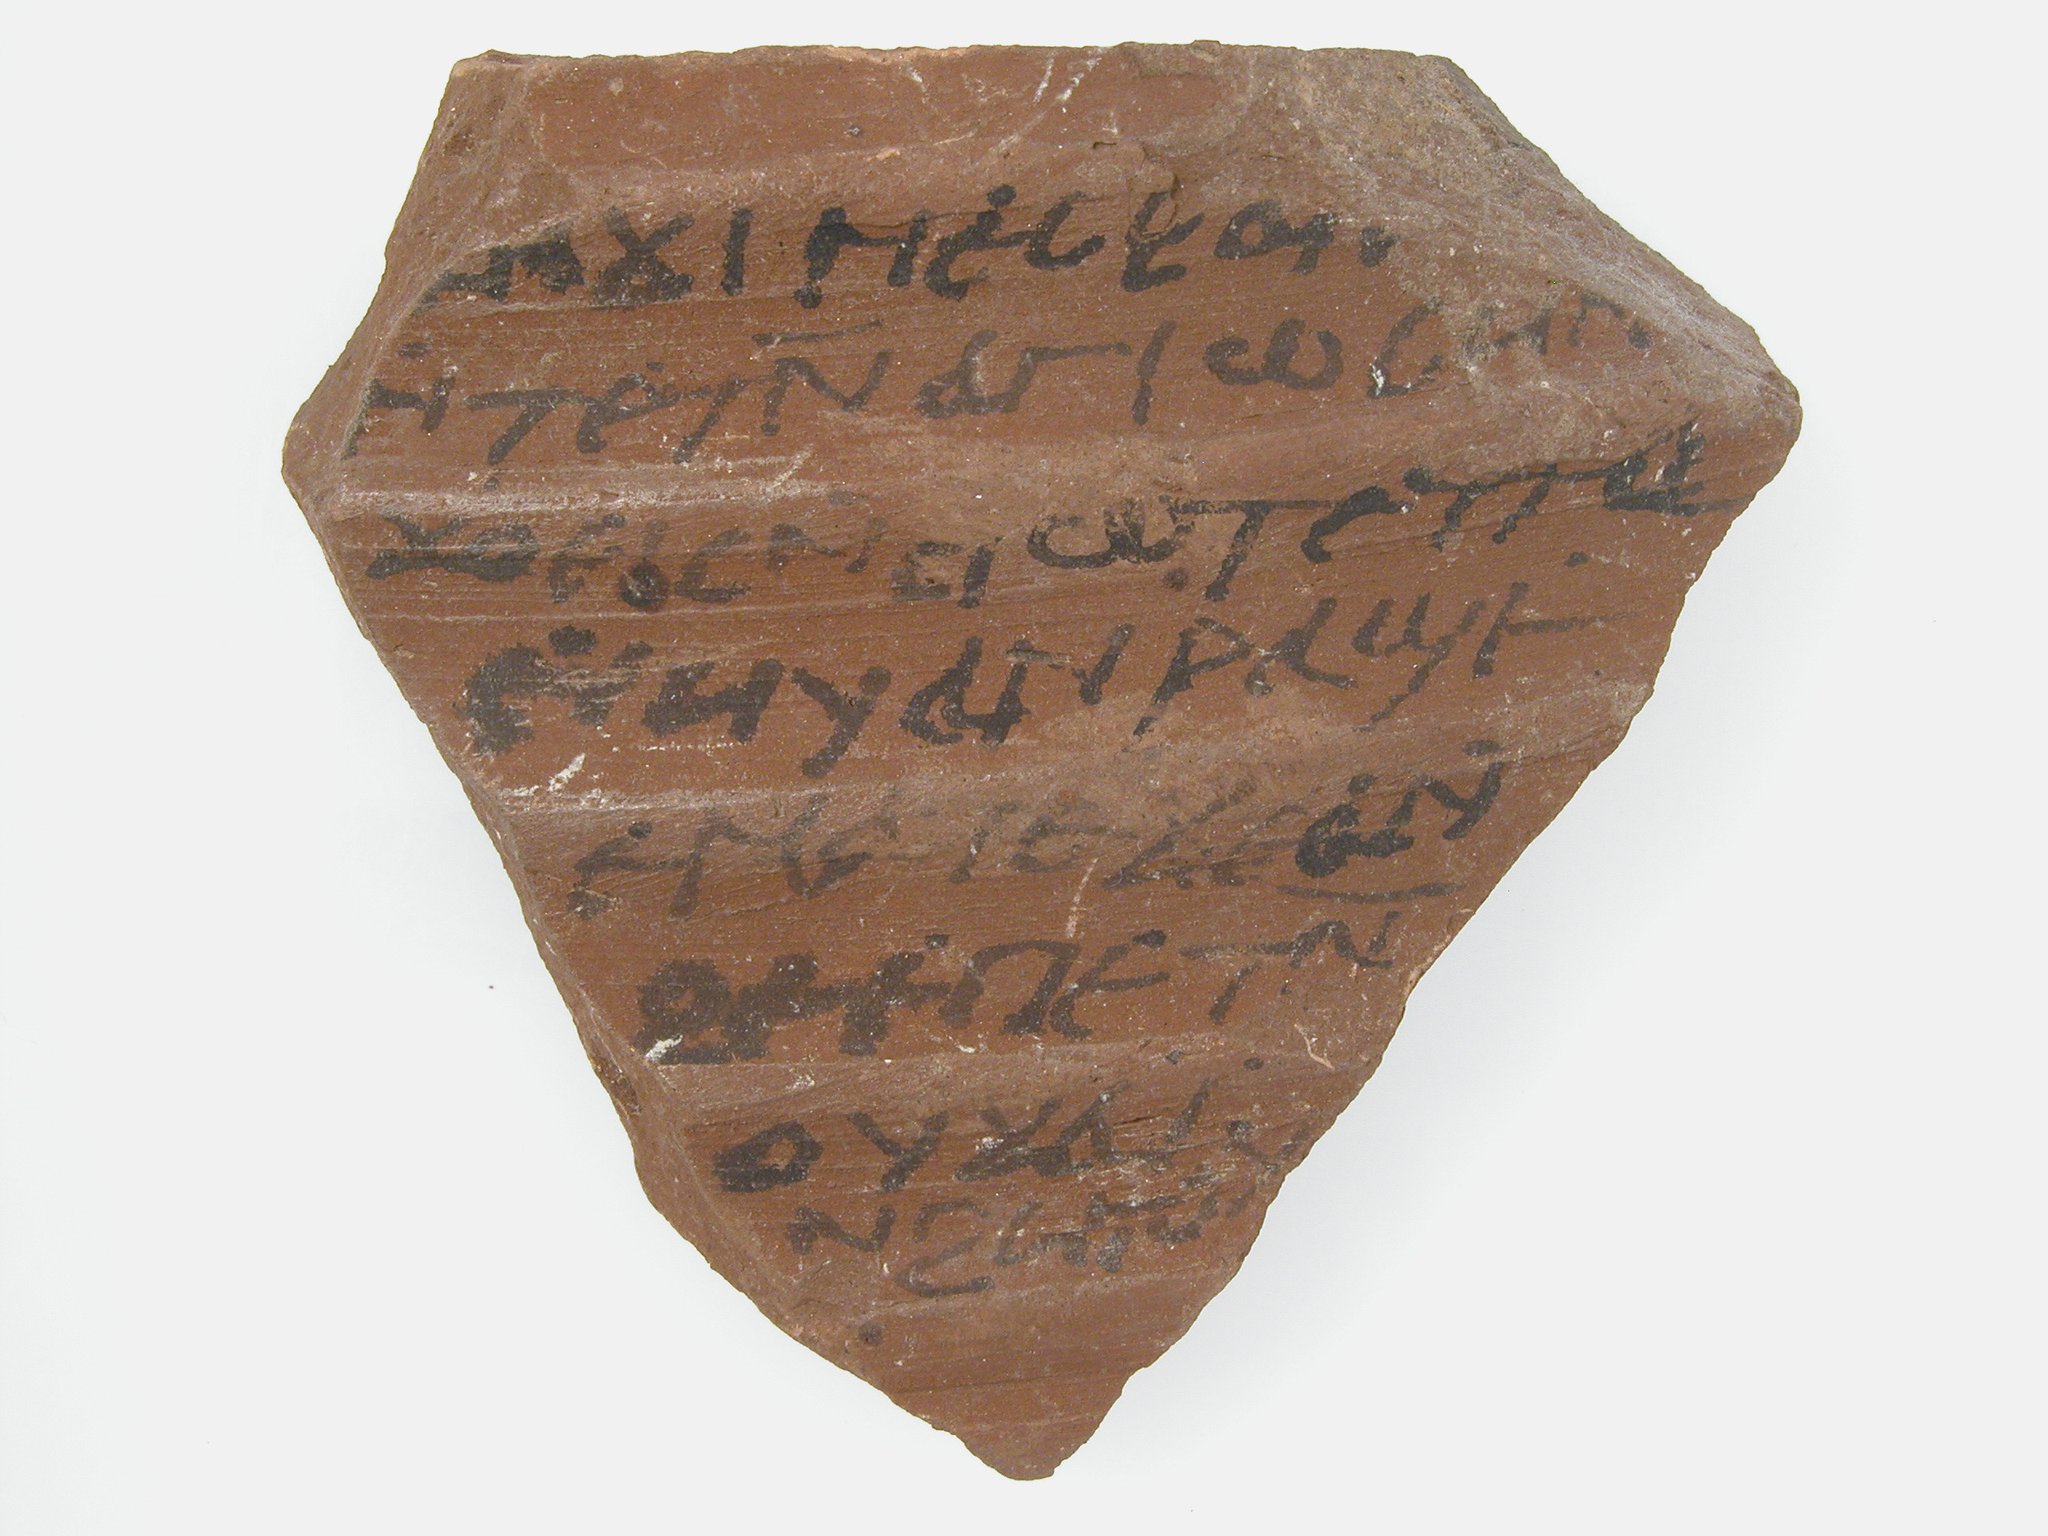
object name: ostrakon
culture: coptic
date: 600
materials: ink, pottery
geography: egypt